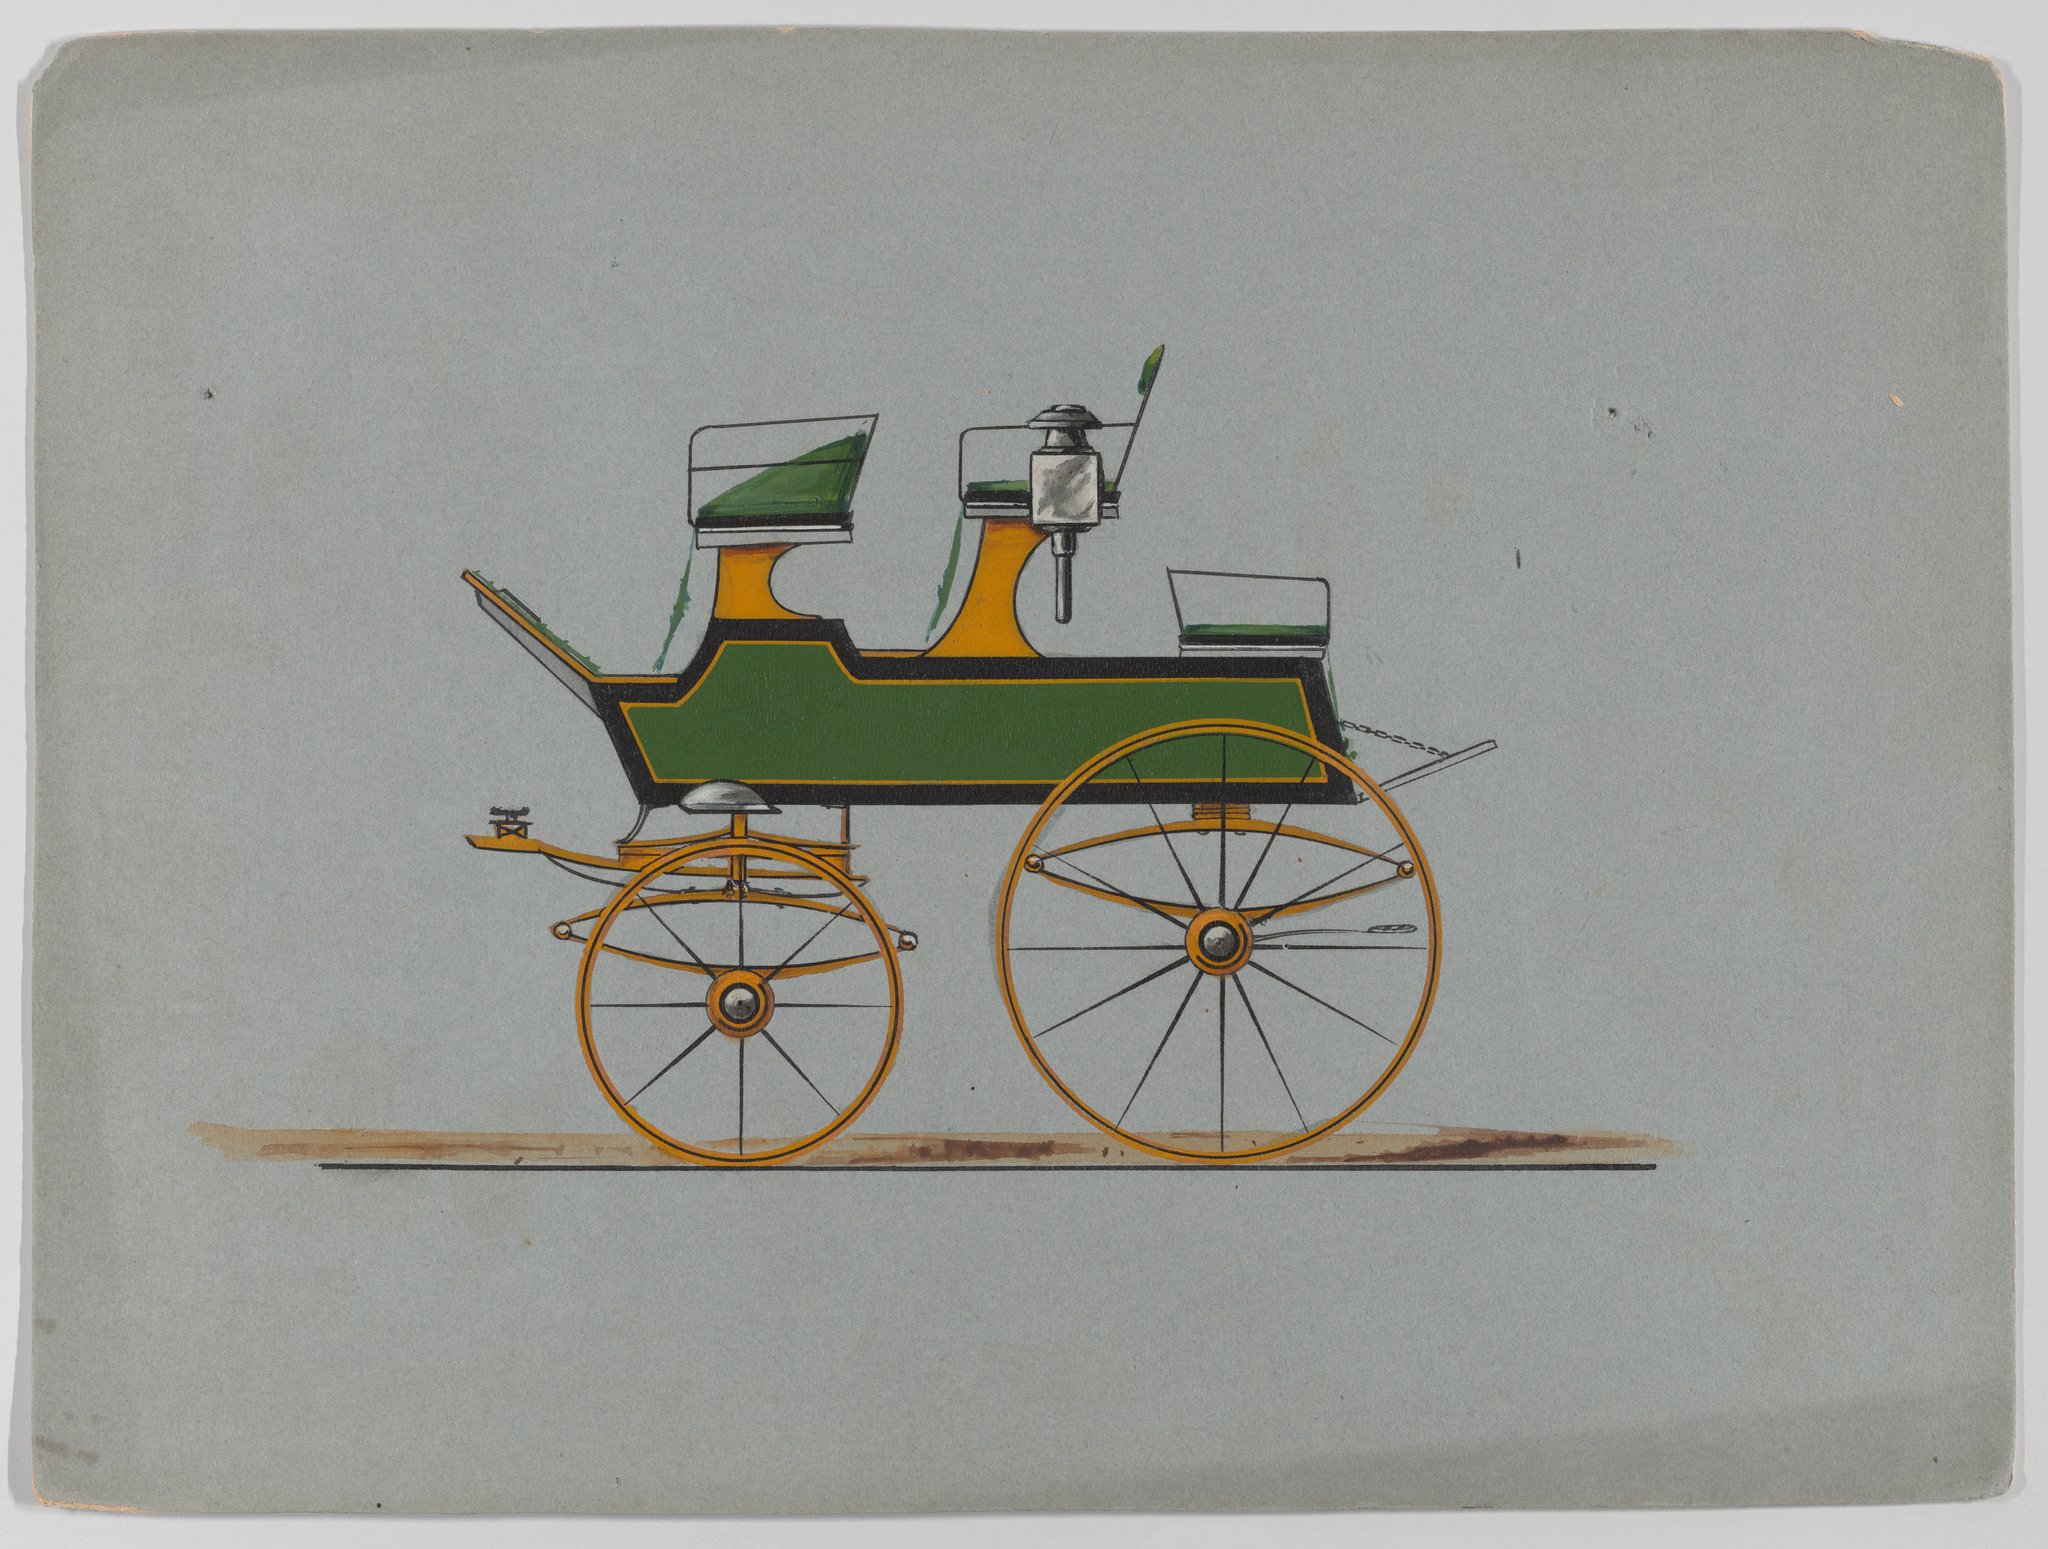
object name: drawing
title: Design for Break (unnumbered)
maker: brewster & co.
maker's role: manufacturer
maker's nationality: american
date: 1870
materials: gouache, gum arabic, ink, watercolor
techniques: pen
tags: carriages